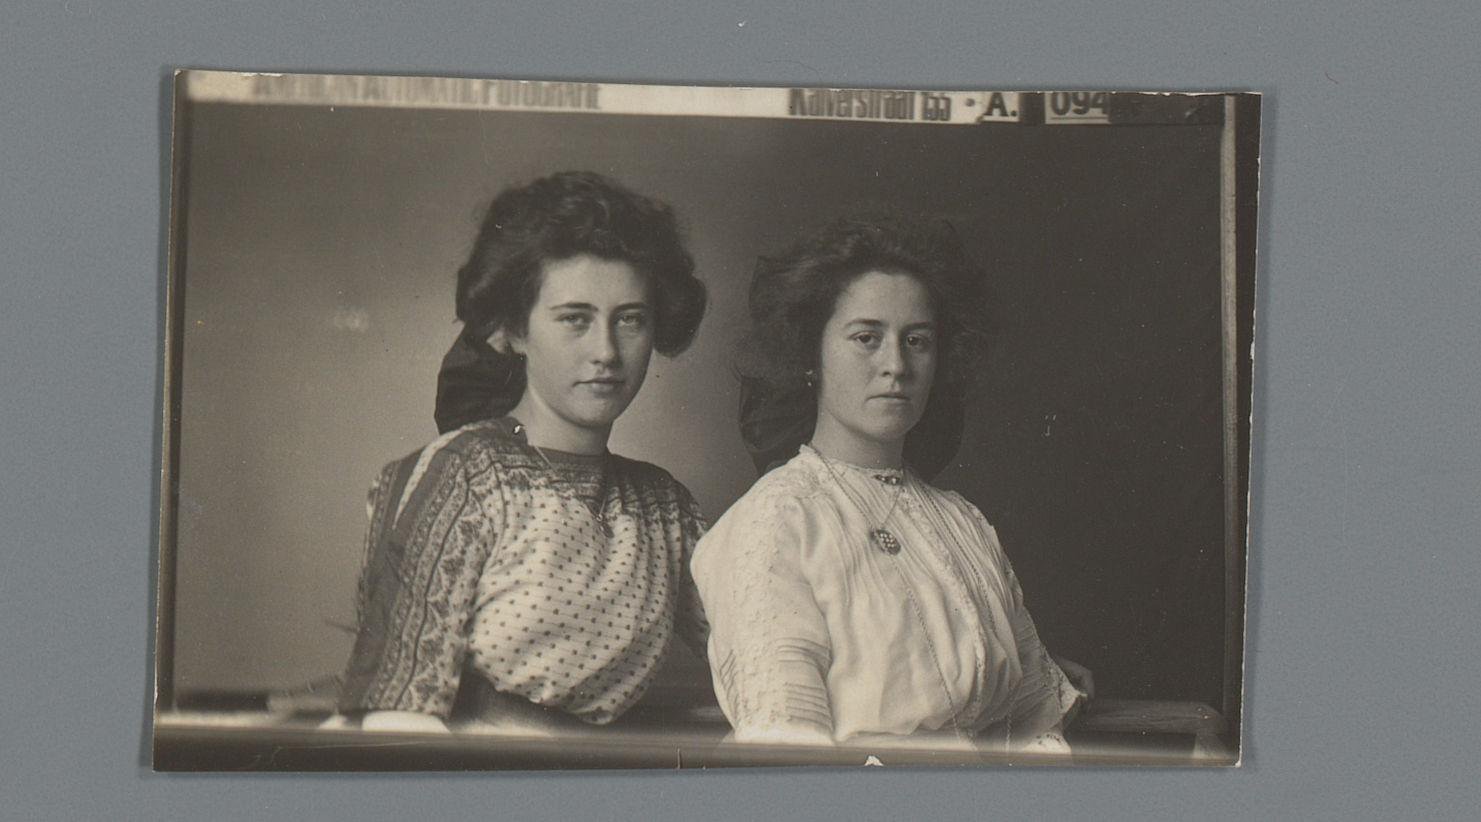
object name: snapshot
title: Rapid photographs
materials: paper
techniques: gelatin silver print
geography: amsterdam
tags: adolescent, young woman, maiden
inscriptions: address: ‘Kalverstraat 155’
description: Between 1912 and 1930, anyone could have their portrait taken at the many so-called rapid photography studios in the shopping streets of mainly (medium) large-size European cities. As if on an assembly line, the youngest clerk shot the photographs with a special camera and in artificial light and developed them. Later in the day, the customer collected a sheet with 12 portrait photos for 25 cents. This form of photographic mass production gave rise to a fascinating tableau of boys, girls, men and women not previously seen in photographs; candid and informal. There were at least 150 quick-photo studios, from Alkmaar to Zutphen. Many called themselves ‘American,’ mistakenly as it turns out because hardly any examples from that country have been found.